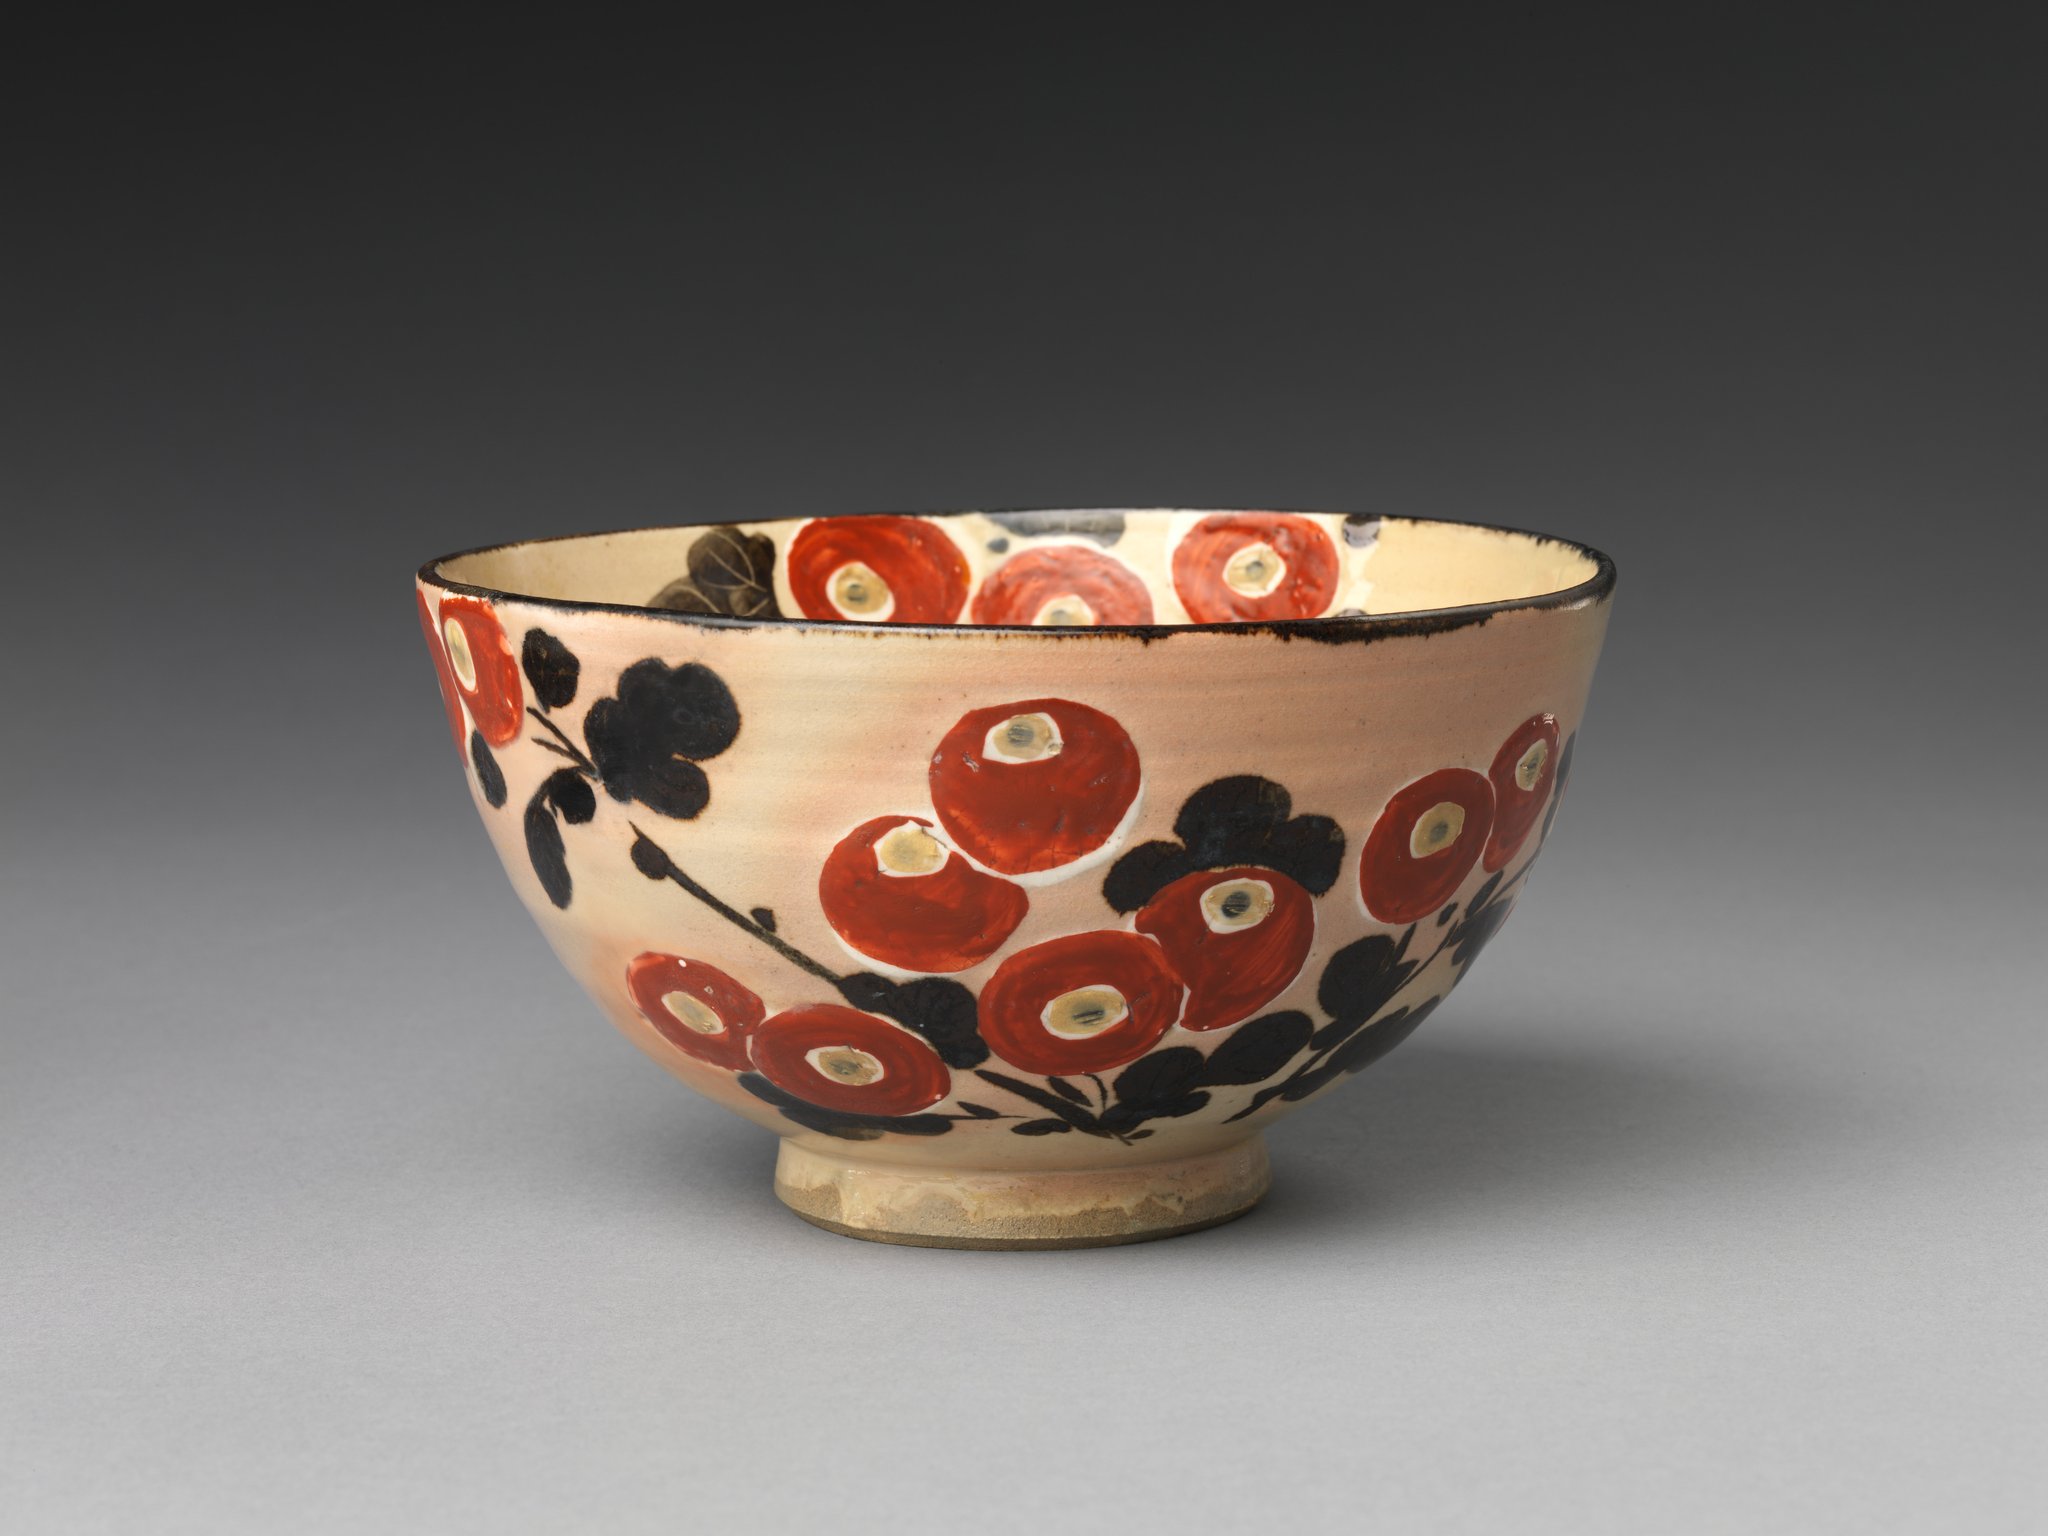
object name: bowl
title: Bowl with blossoms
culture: japanese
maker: nin'ami dōhachi (takahashi dōhachi ii)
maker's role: artist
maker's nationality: japanese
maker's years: 1783-1855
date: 1801-1900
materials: enamel, stoneware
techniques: polychrome